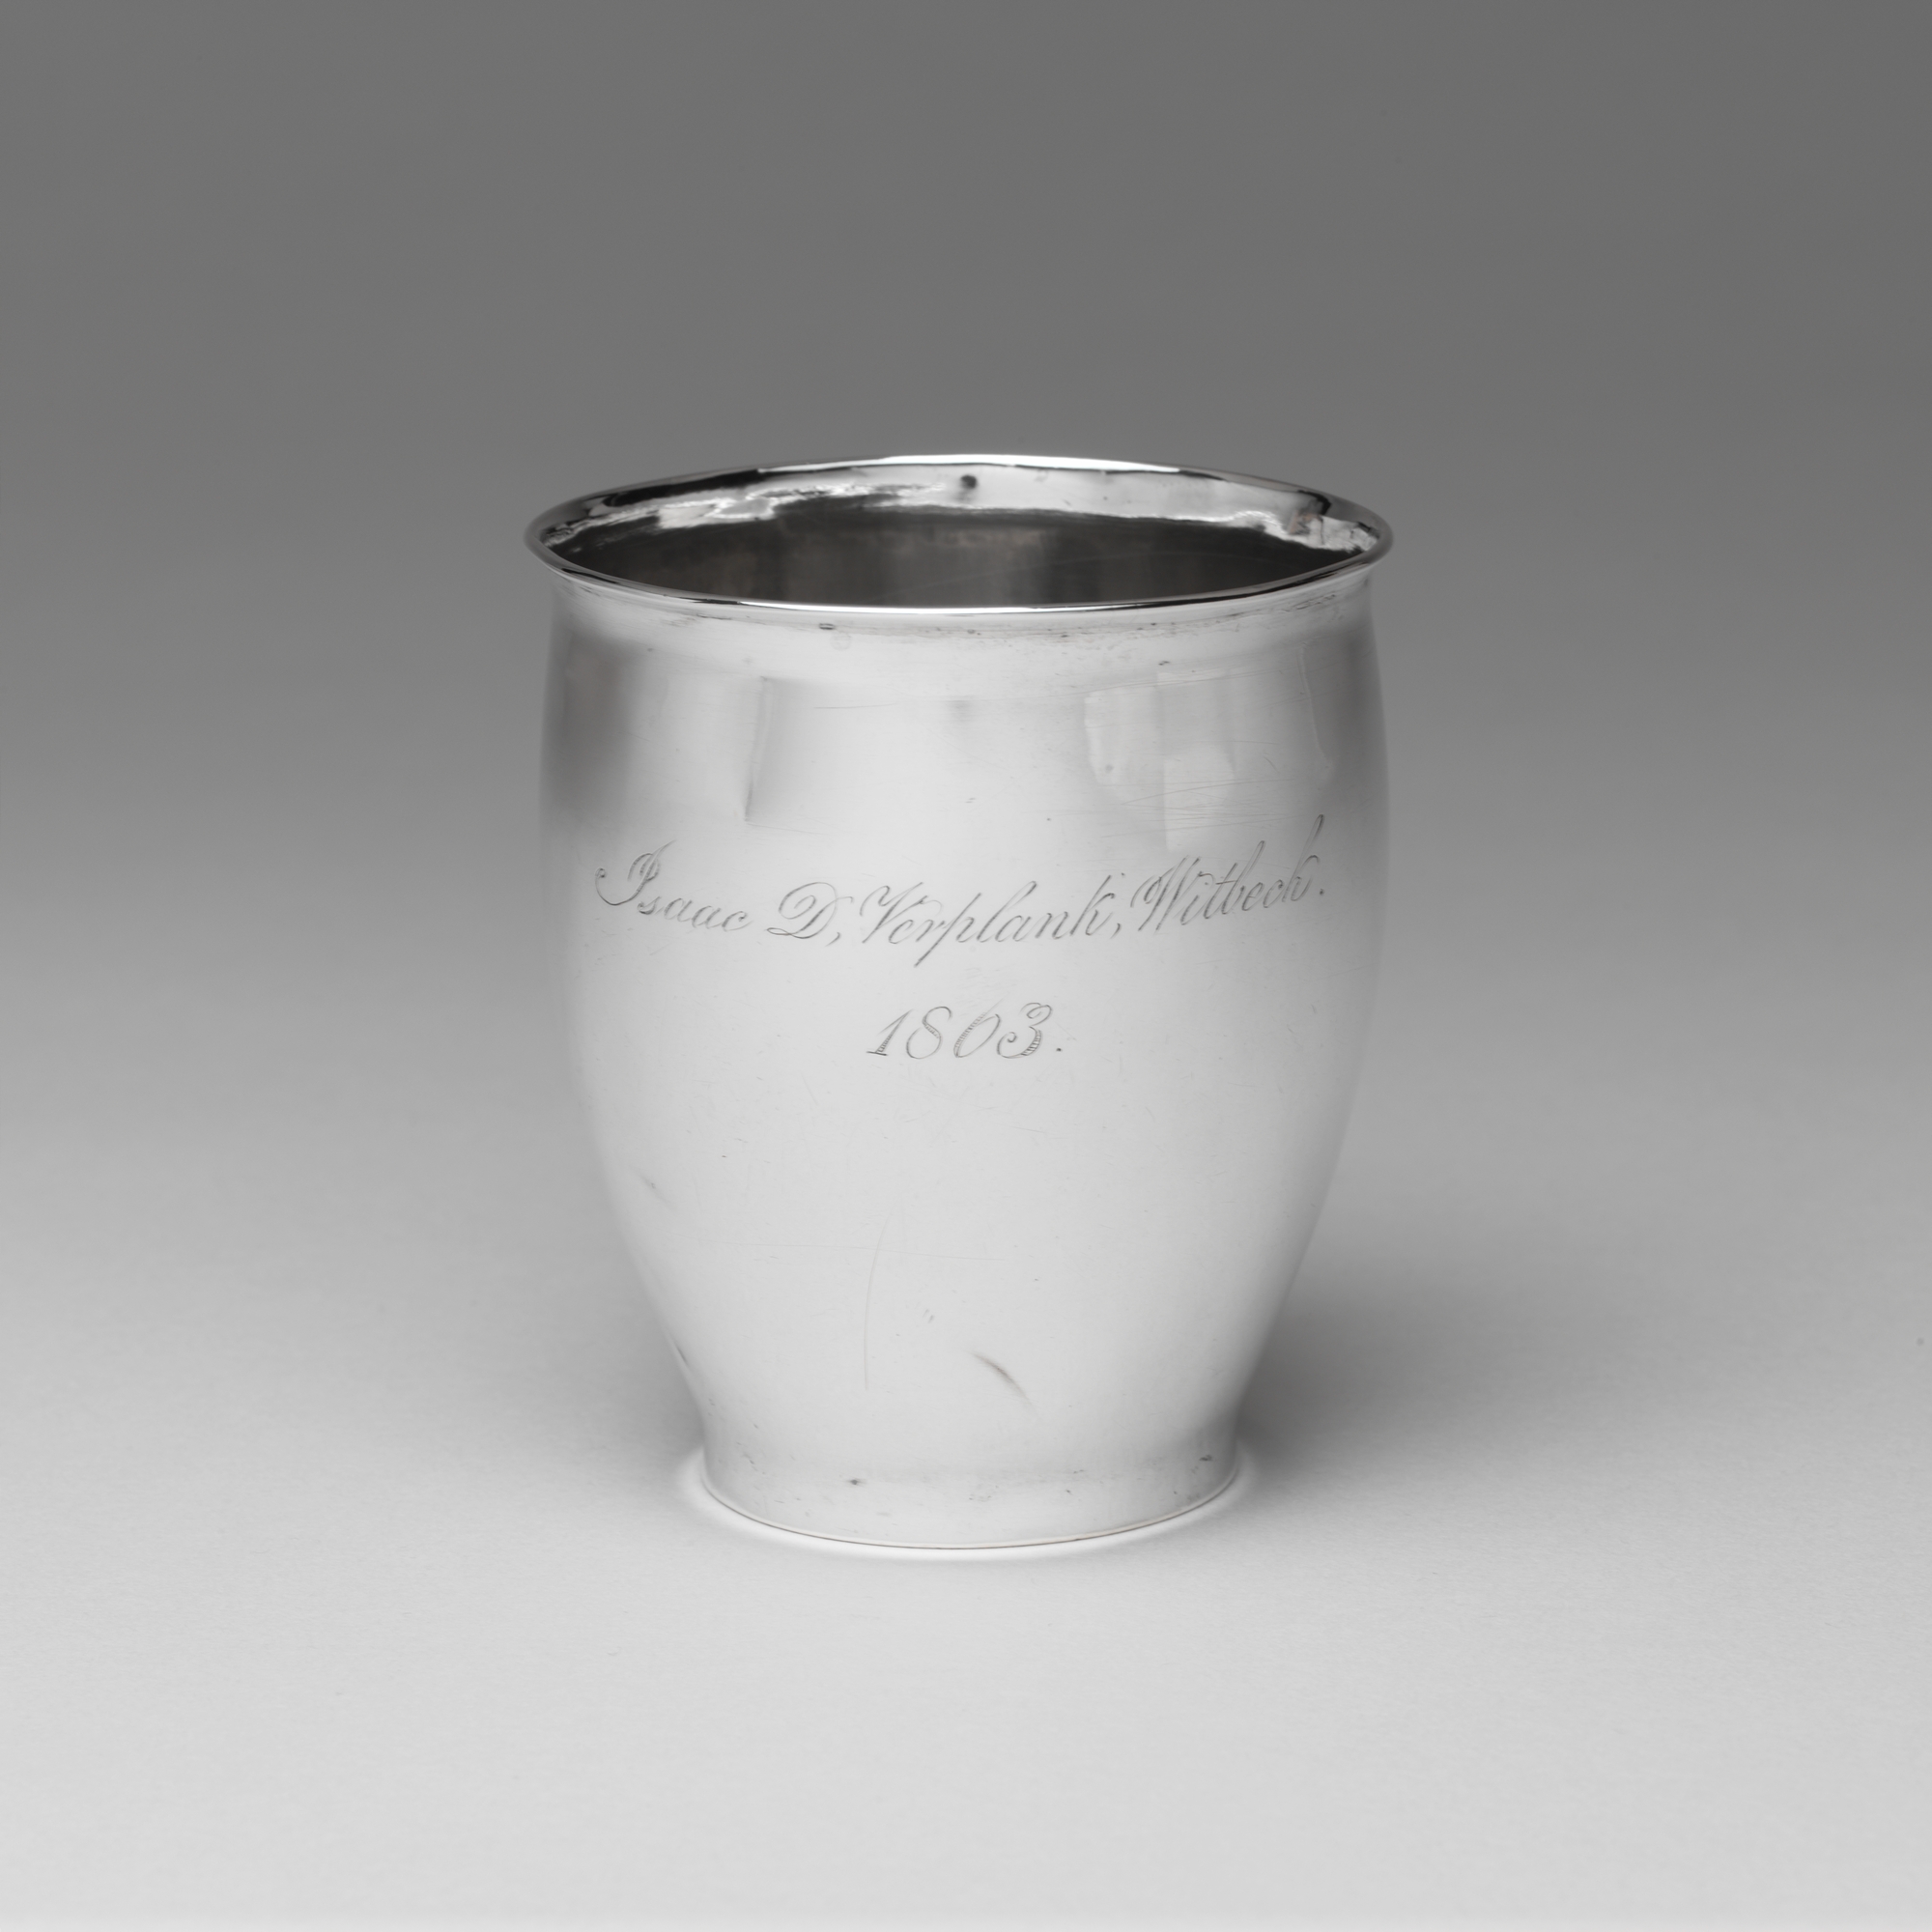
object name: beaker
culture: american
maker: isaac hutton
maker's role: maker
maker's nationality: american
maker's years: 1766-1855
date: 1800-1830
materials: silver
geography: united states